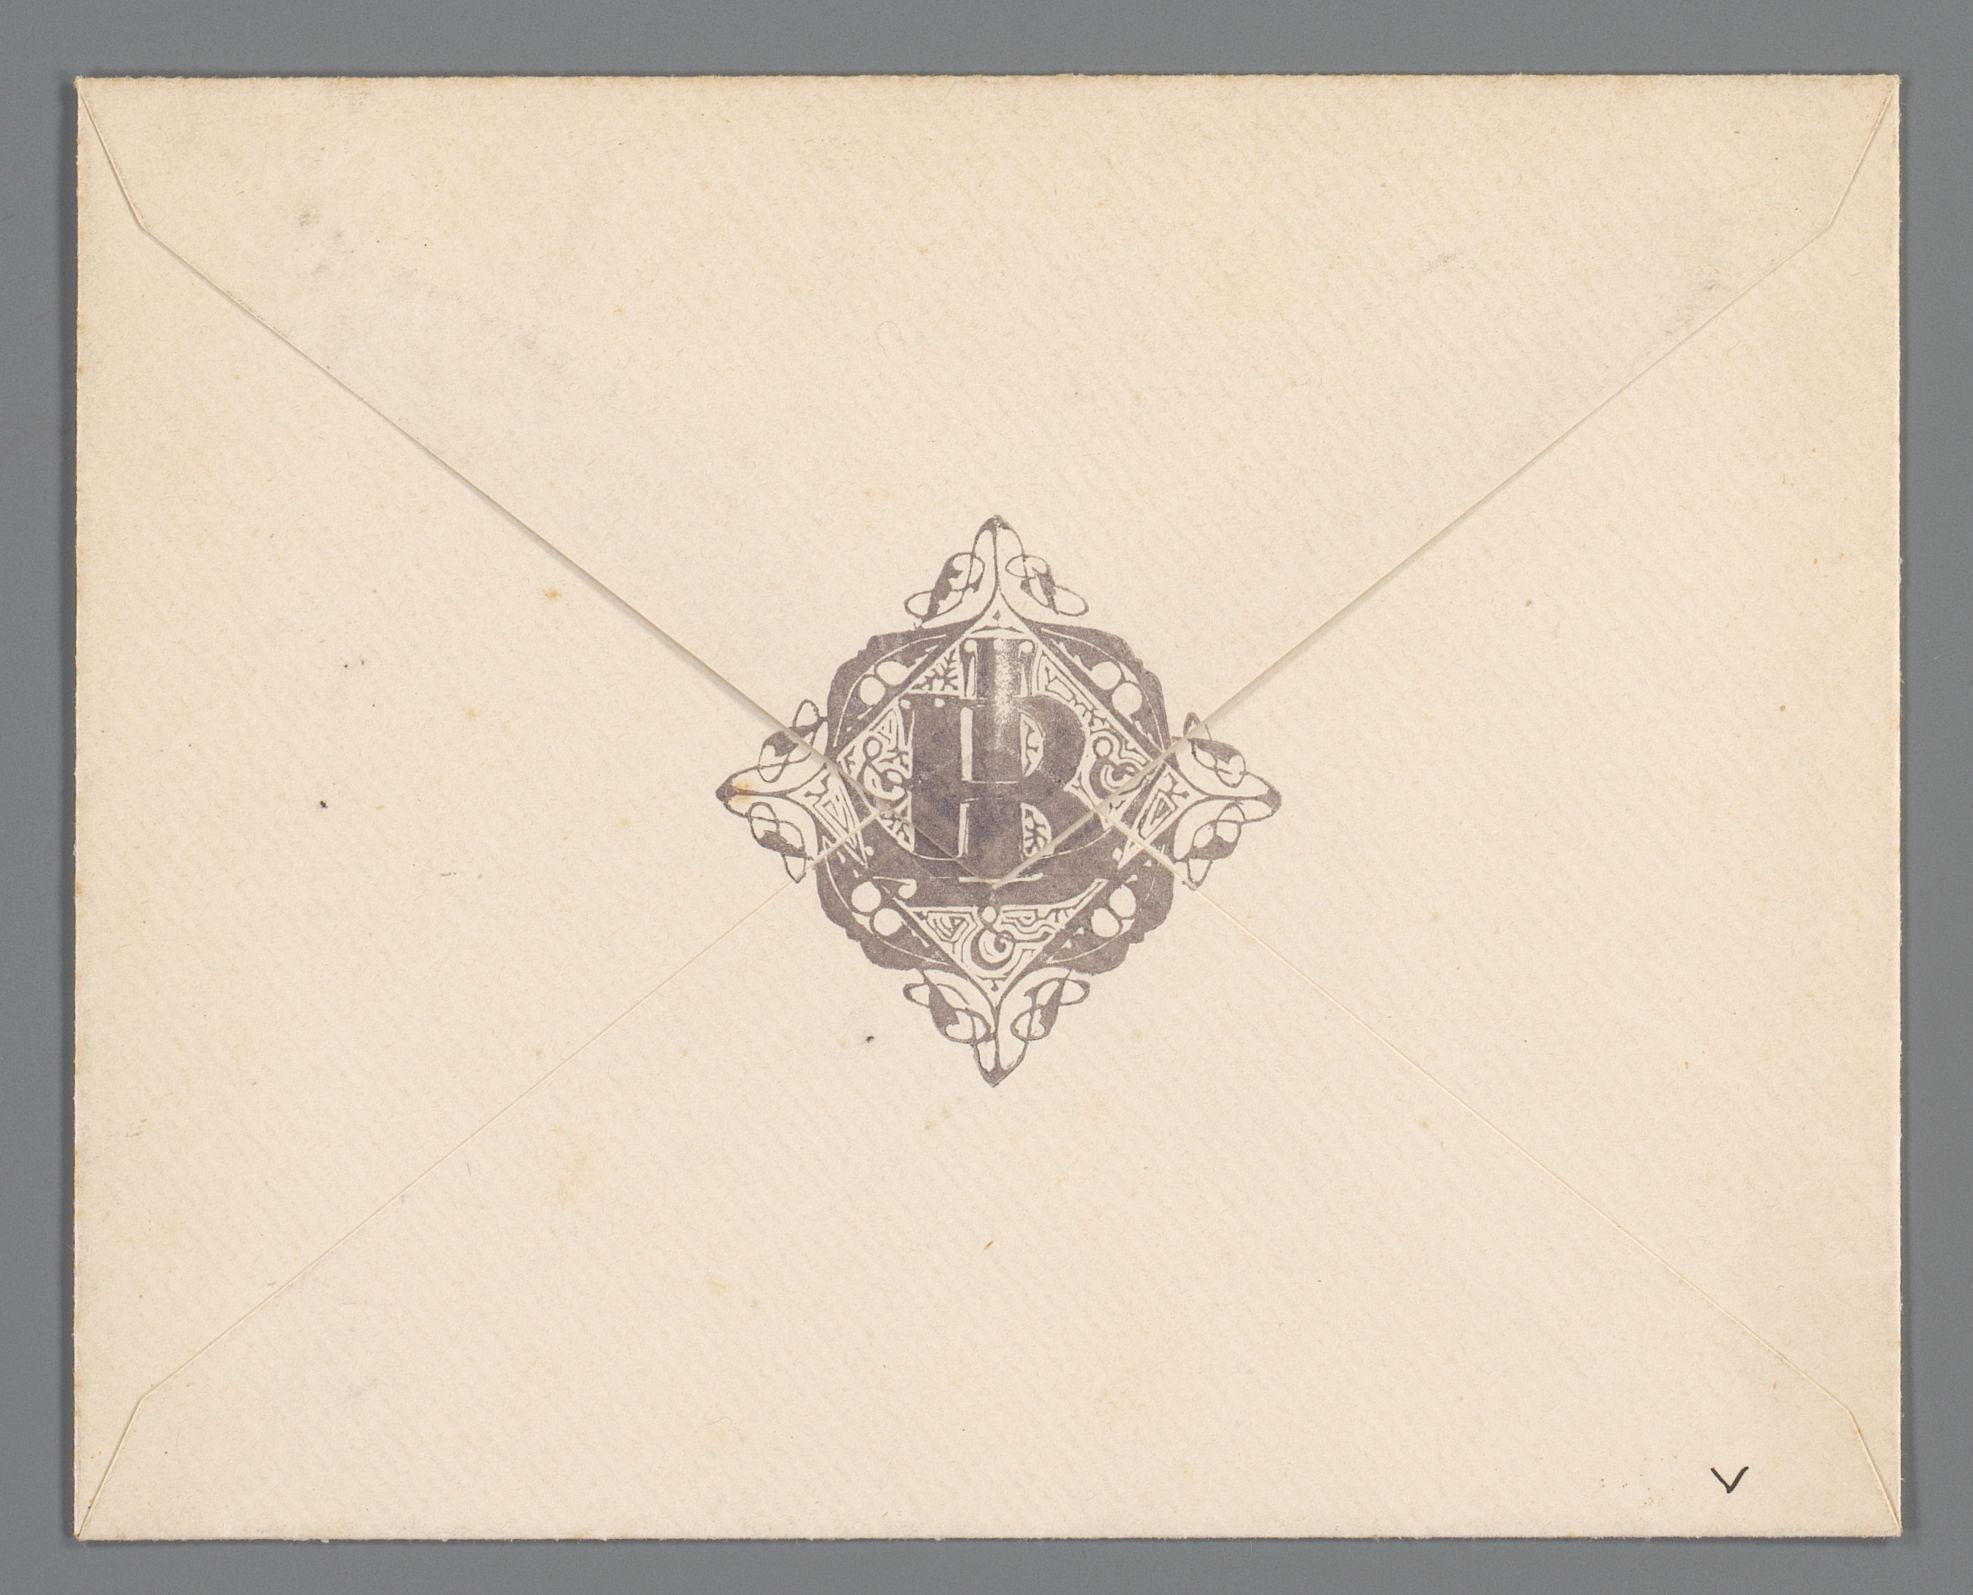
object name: envelope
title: Envelop met vignet met monogram van De Bazel en Lauweriks als sluitzegel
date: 1890-1900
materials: paper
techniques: woodcut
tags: den helder, amsterdam, print maker, draughtsman, karel petrus cornelis de bazel, designer, mathieu lauweriks, fantasy ornament